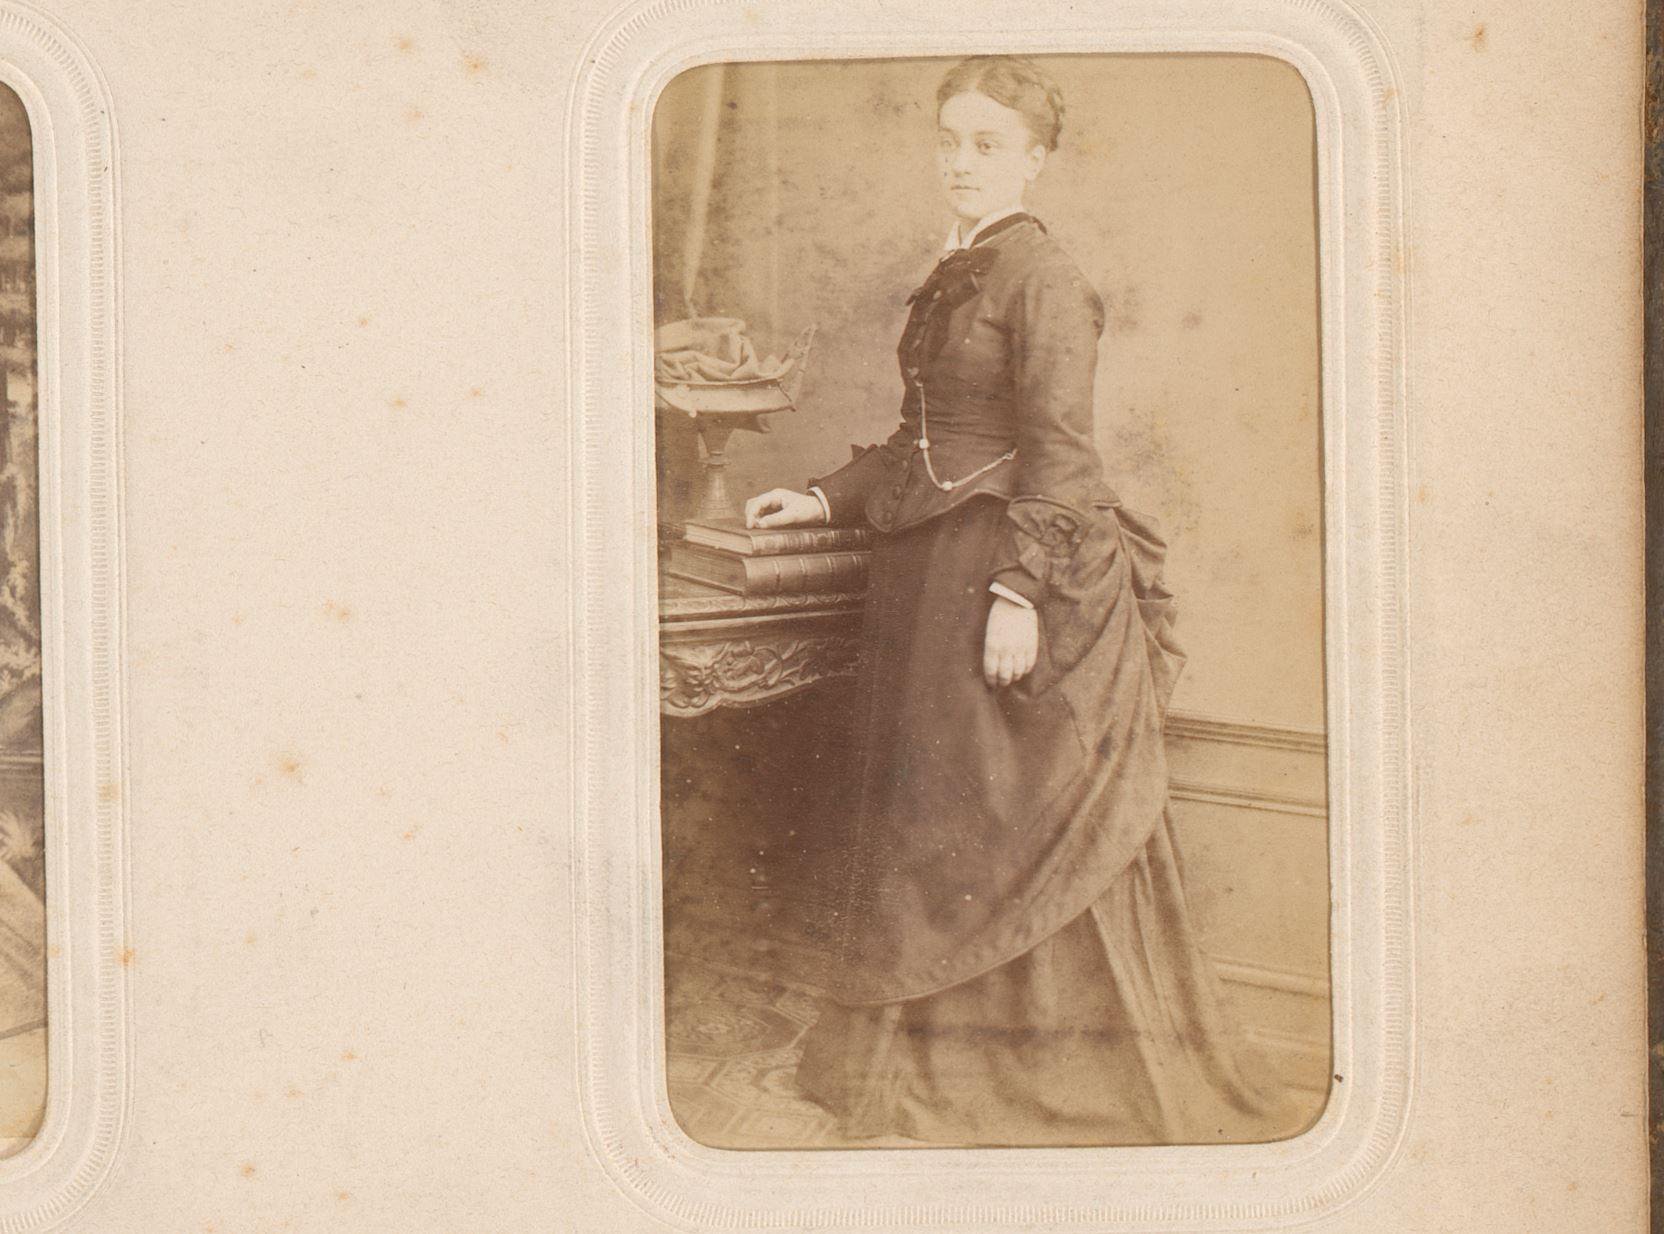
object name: photograph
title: Portret van een vrouw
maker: branchut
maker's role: fotograaf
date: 1875-1900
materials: cardboard, photographic support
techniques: albumen print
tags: historical persons, book, standing figure - aa - female human figure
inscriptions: inscription: ‘Ancienne Maison Lejeune/ Branchat, Succr/ Rue de Rivoli, 106/ Paris/ (...)’